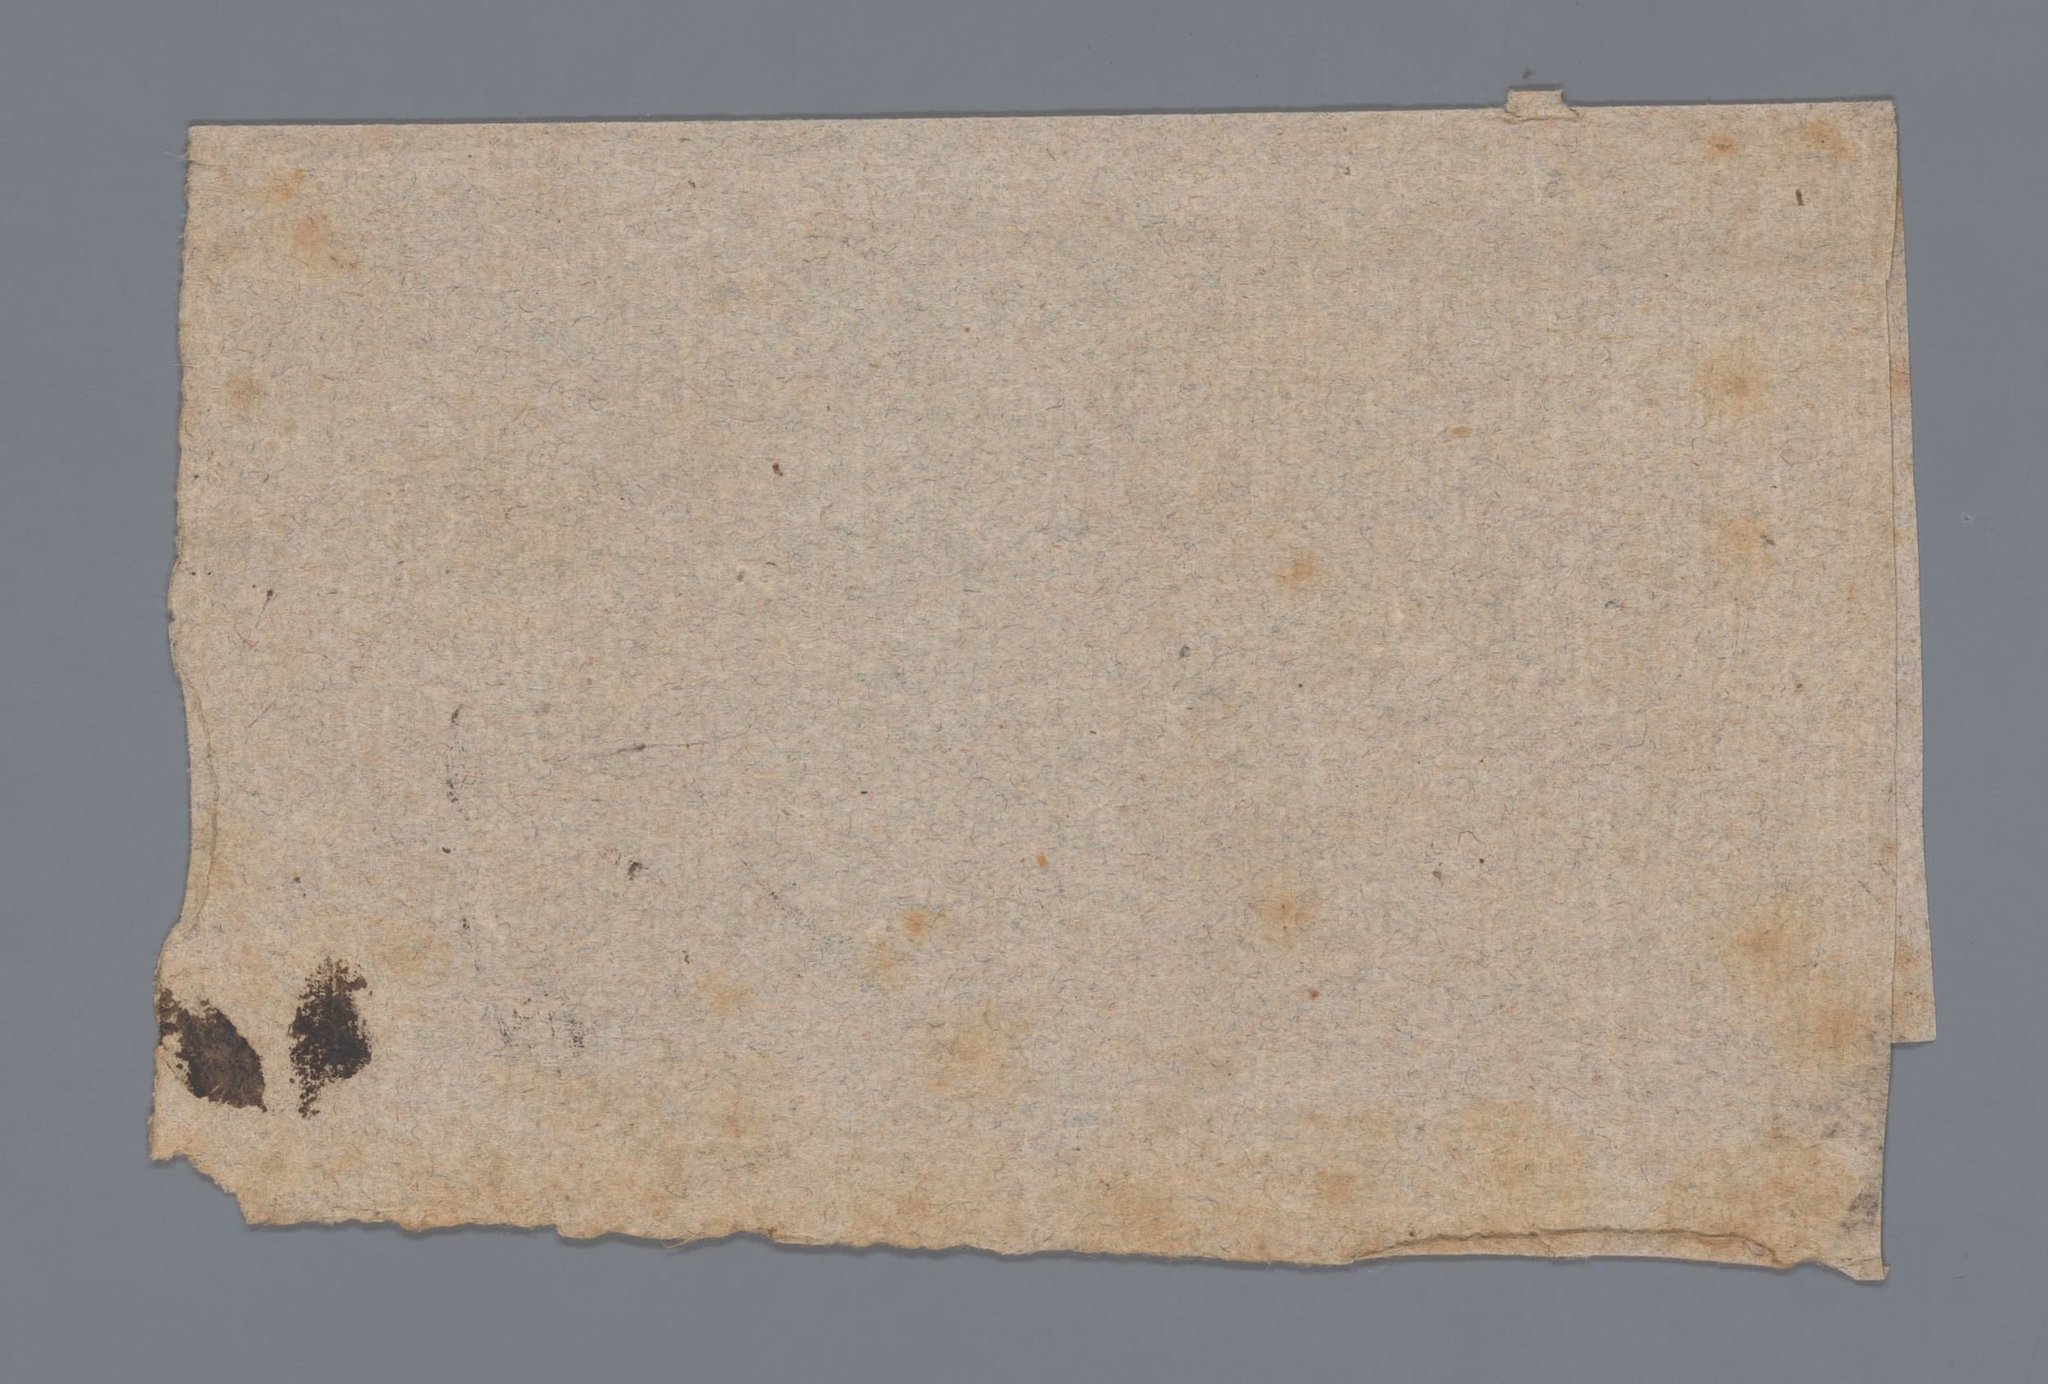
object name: letter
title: Liebste kinder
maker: henriëtte solger-gravin van der gröben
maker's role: schrijver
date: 1829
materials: ink, paper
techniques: folding, writing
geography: germany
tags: the hague, johan rudolf thorbecke, germany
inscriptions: date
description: Brief aan de kinderen van 3 pagina's in zwarte inkt geschreven. Vel gevouwen in omslag en vloeipapier.